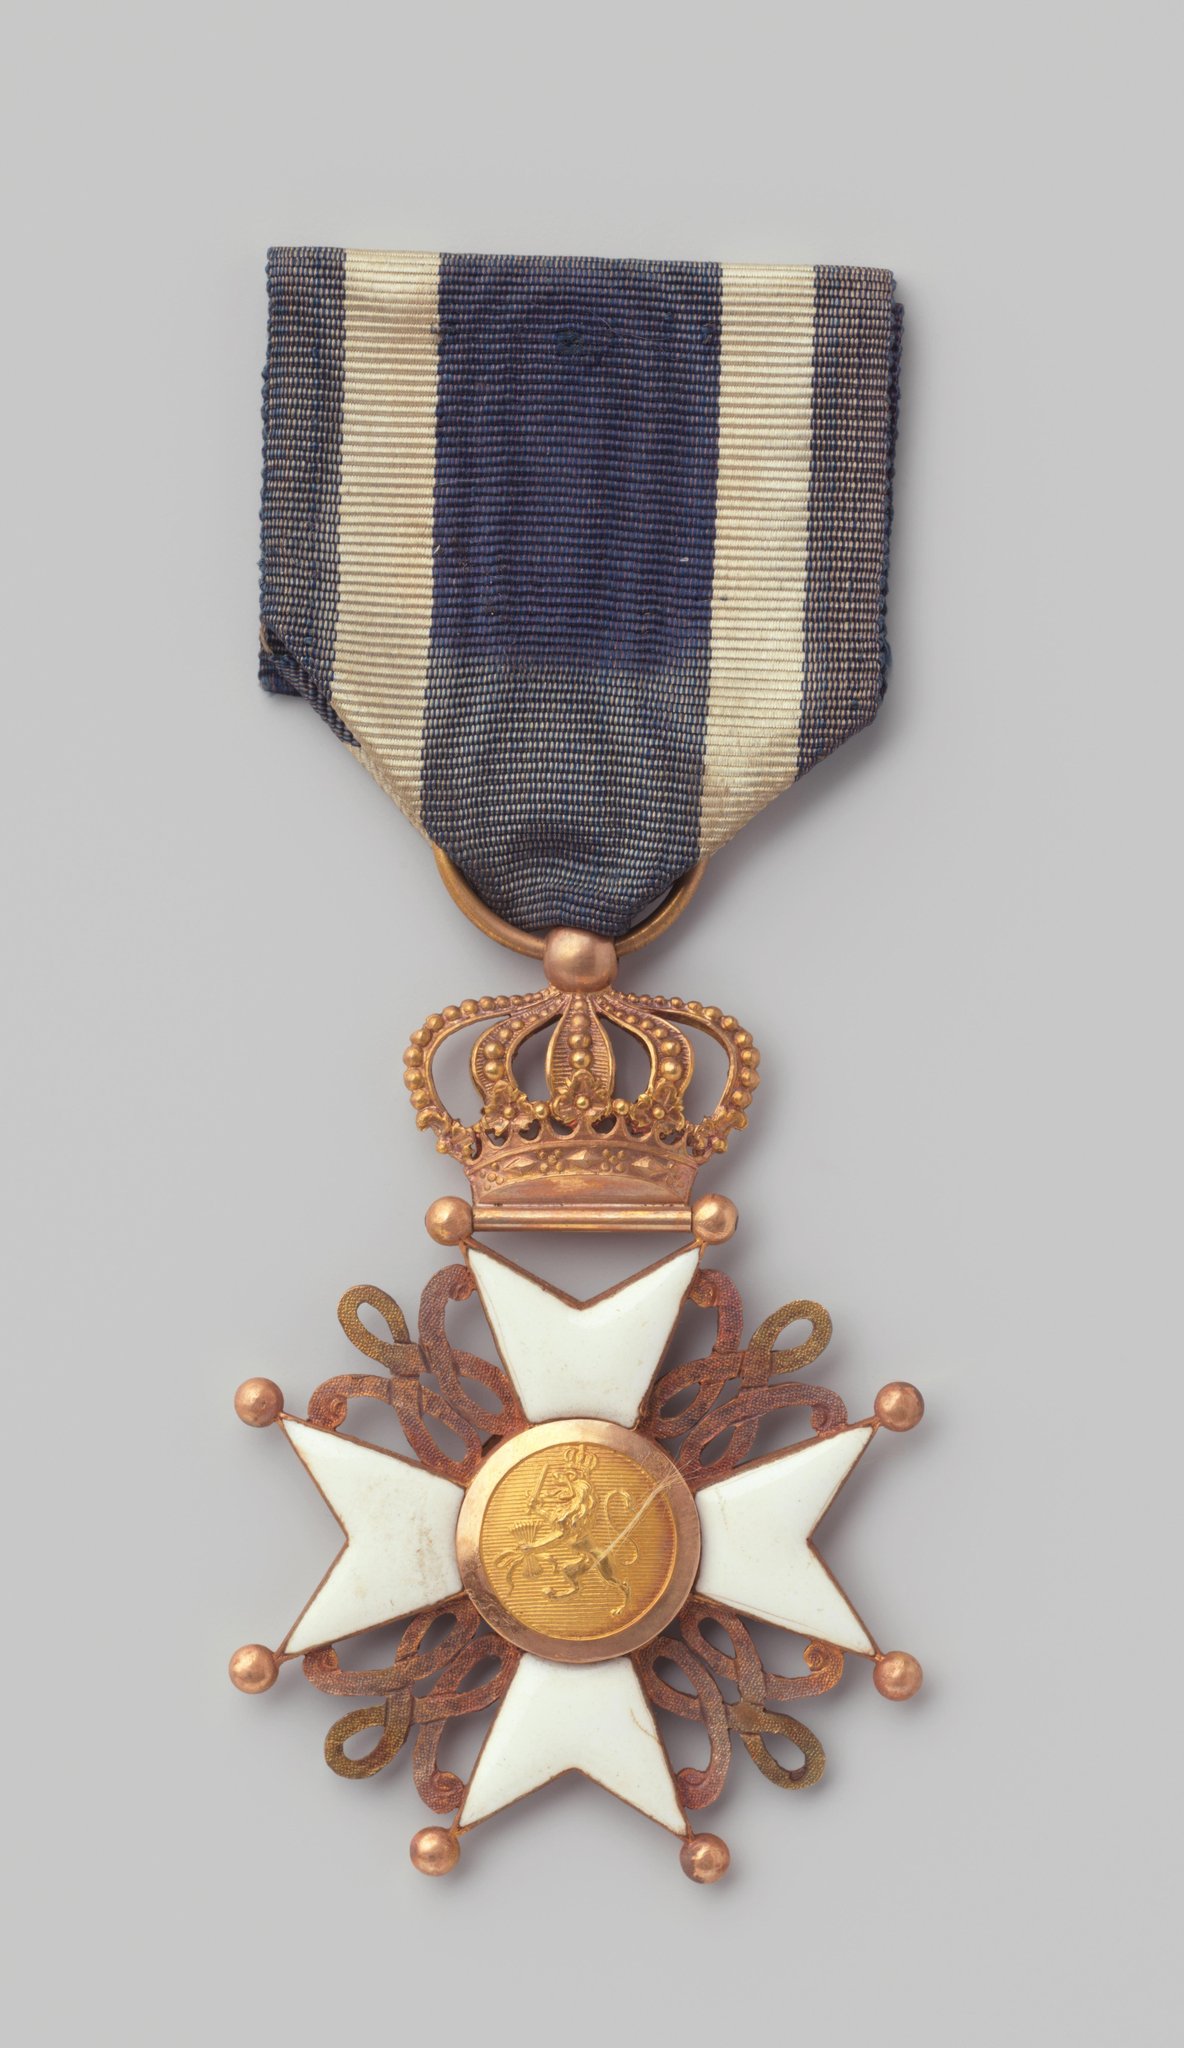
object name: onderscheidingsteken, onderscheiding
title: Ridderkruis van Orde van de Nederlandse Leeuw met blauw-oranje lint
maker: Anonymous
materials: metal, textile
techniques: forging, striking, weave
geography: netherlands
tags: orde van de nederlandse leeuw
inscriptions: : ‘VIRTUS NOBILITAT’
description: Het Ridderkruis van Orde van de Nederlandse Leeuw, bestaat uit een goudkleurige onderscheiding met lint. In het midden van de onderscheiding een goudkleurige medaillon waarop de Nederlandse Leeuw staat afgebeeld. Tussen de armen goudkleurig gestylleerde W's. Aan de andere zijde is het medaillon blauw geëmailleerd en staat de tekst VIRTUS NOBILITAT. Aan het uiteinde van de armen goudkleurige balpunten. Boven het kruis een goudkleurige kroon welke vastzit aan een ring. Aan de ring het Nassau-blauwe lint waar aan weerzijden twee wit verbleekte verticale strepen lopen.